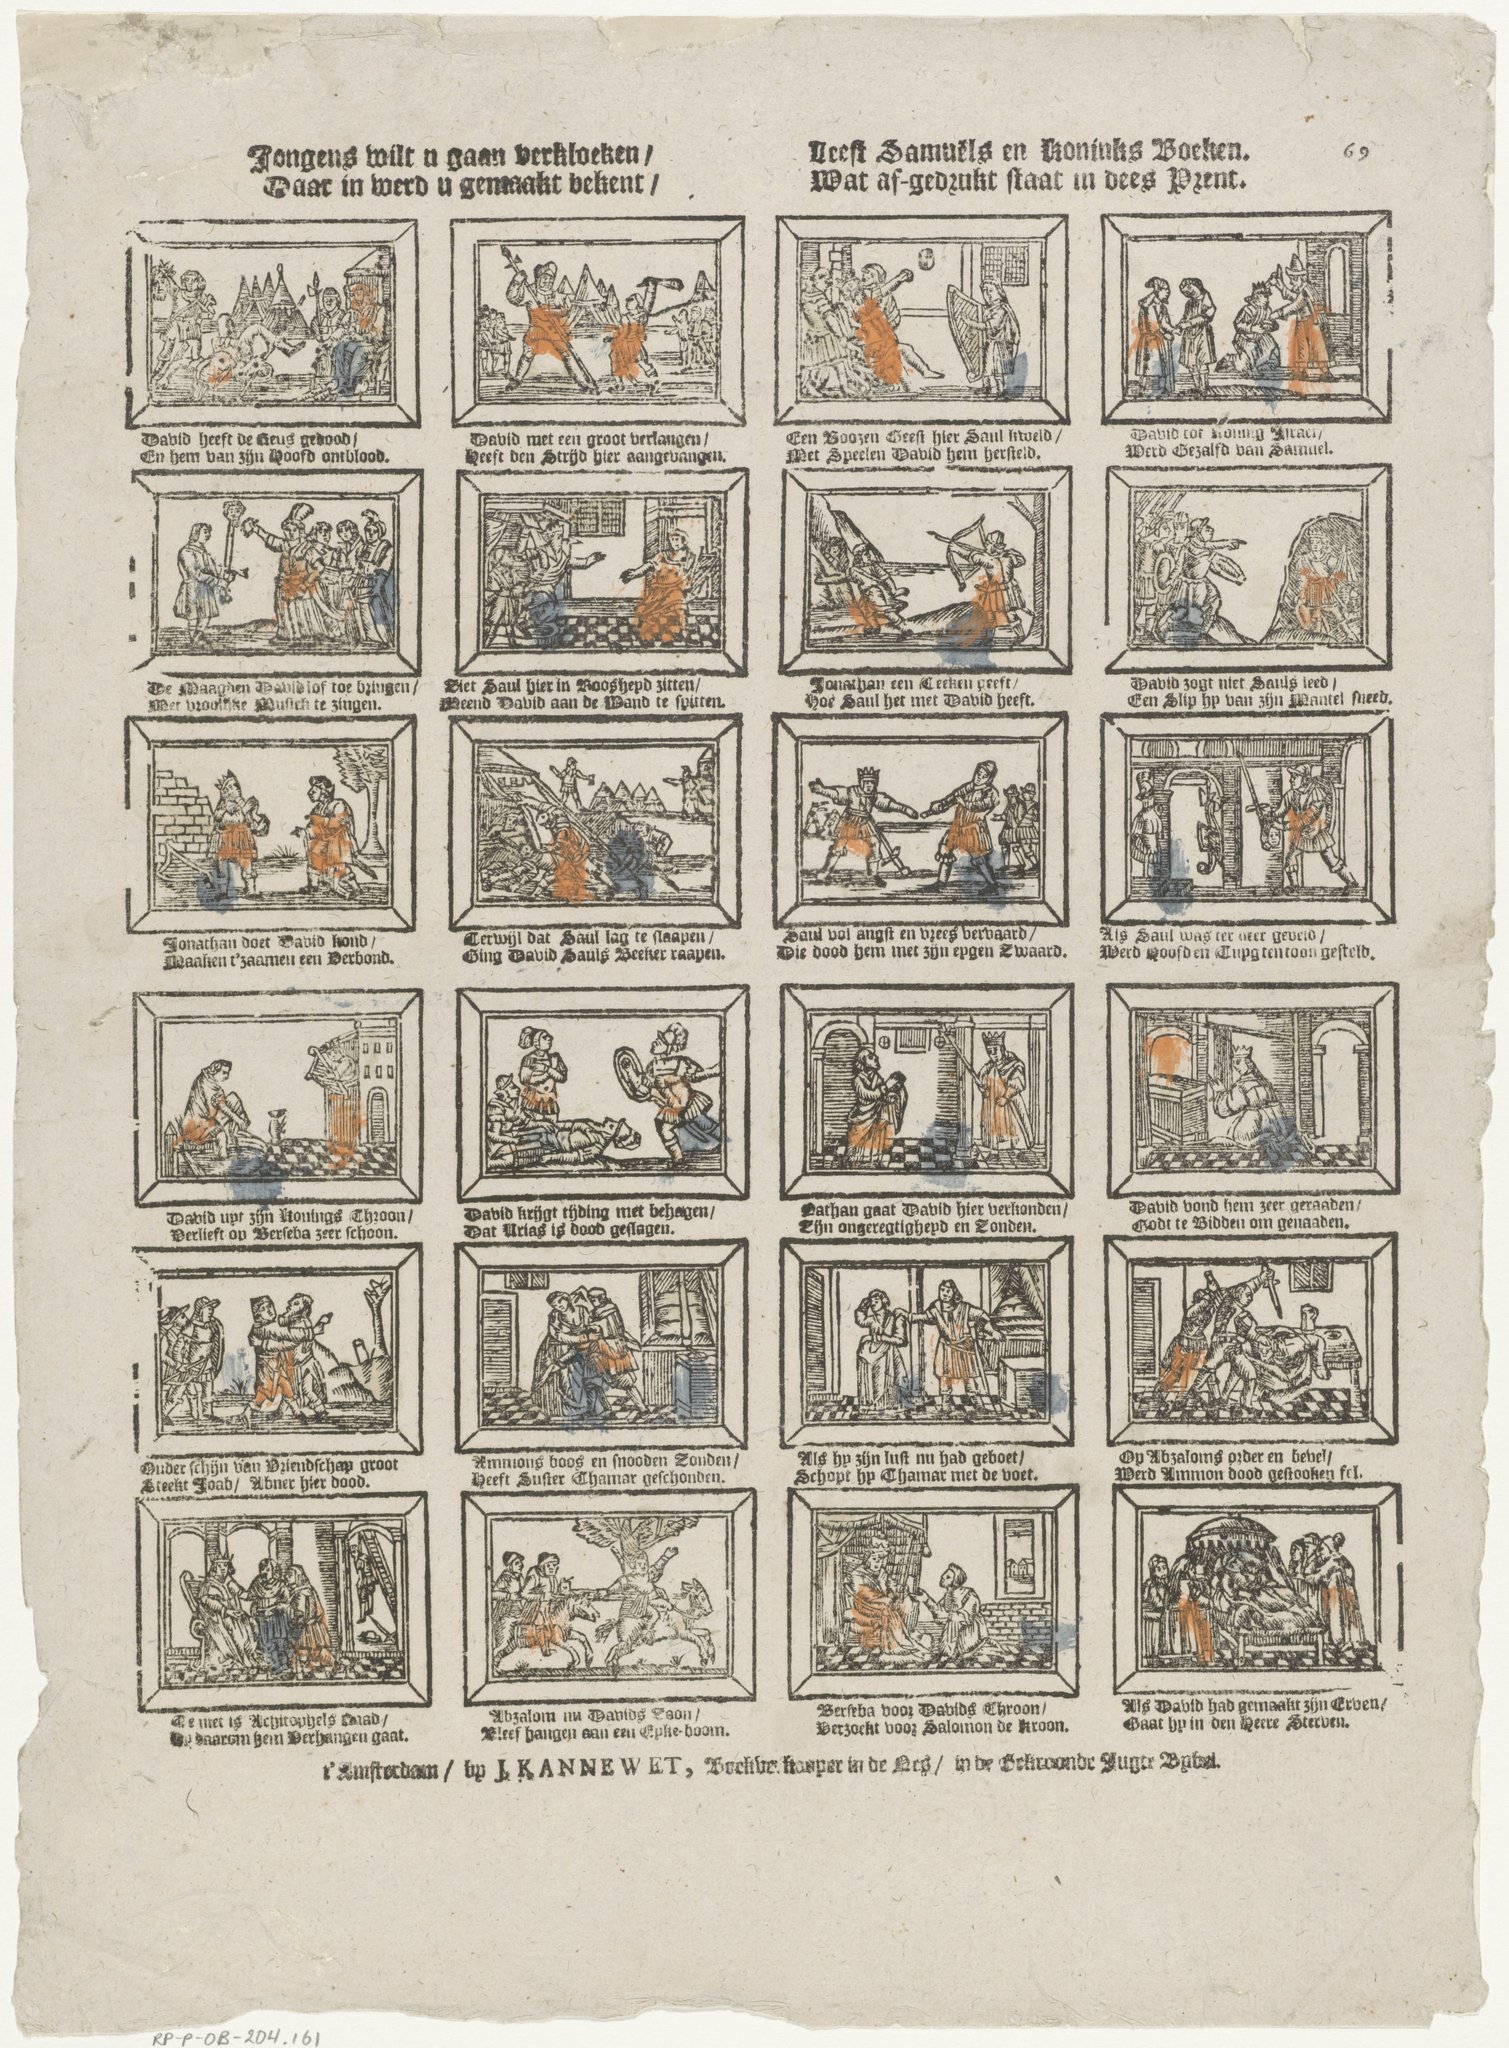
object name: print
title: Jongens wilt u gaan verkloeken / Leeft Samuëls en koninks boeken. / Daar in werd u gemaakt bekent / Wat af-gedrukt staat in dees prent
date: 1725-1780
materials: paper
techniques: colour, letterpress printing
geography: amsterdam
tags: story of david, old testament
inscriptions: collector's mark: Lugt 2760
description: Blad met 24 voorstellingen over het leven van de Oudtestamentische koning David. Onder elke voorstelling een tweeregelig vers. Genummerd rechtsboven: 69.